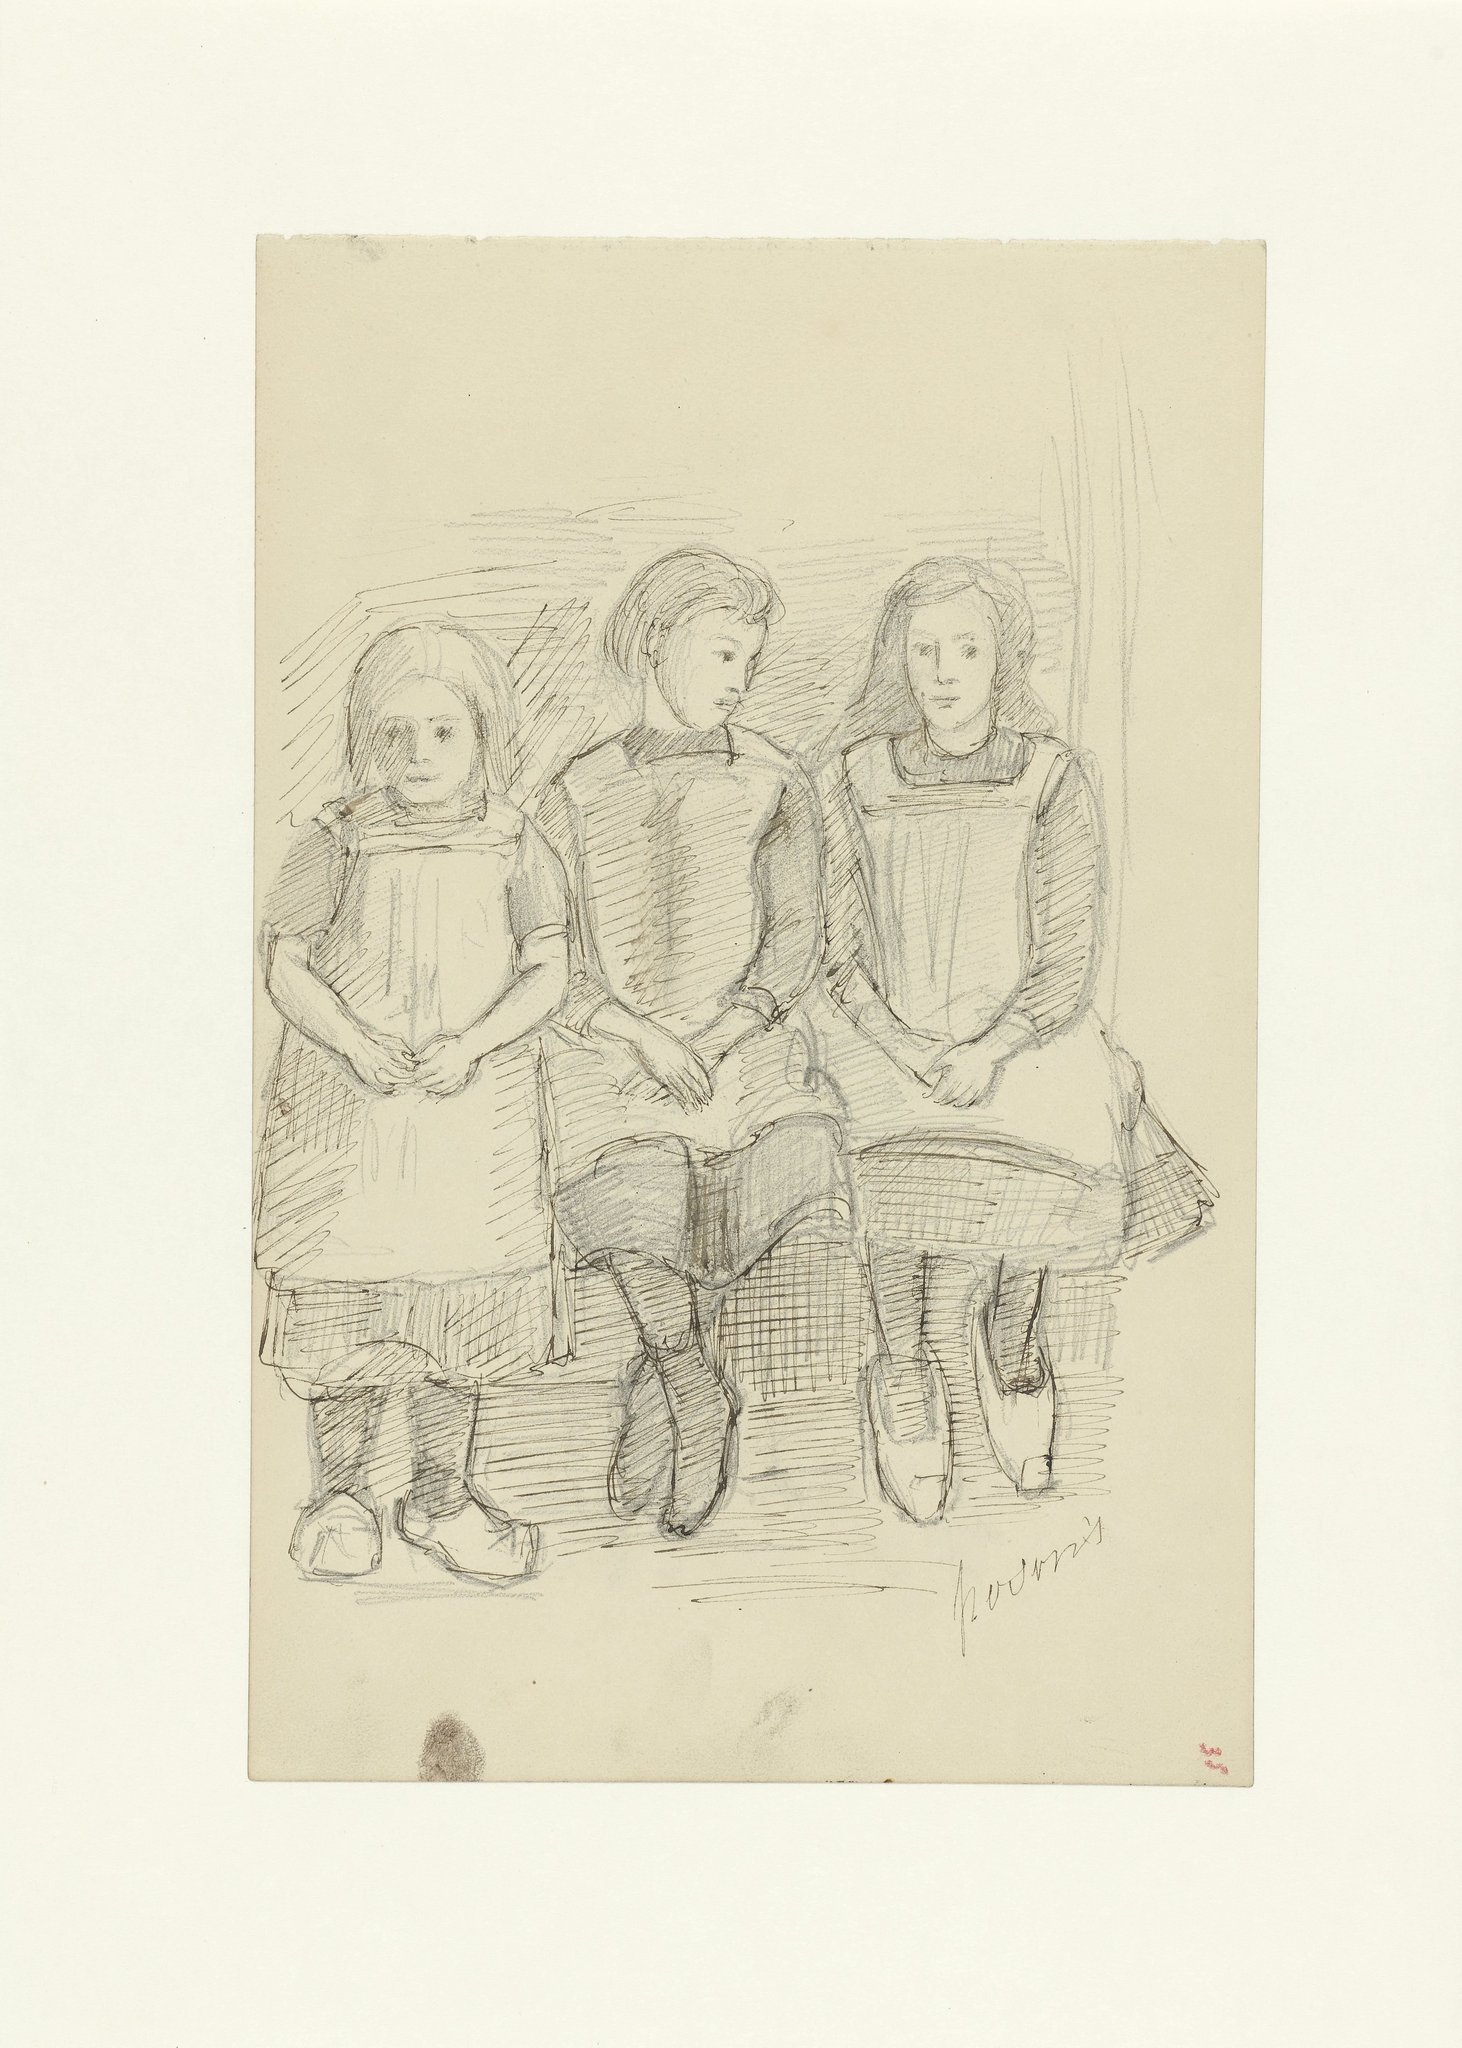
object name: drawing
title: Drie zittende meisjes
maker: jozef israëls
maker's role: draughtsman, painter, print maker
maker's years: 1824-1911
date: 1834-1911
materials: ink, paper, pencil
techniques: pen